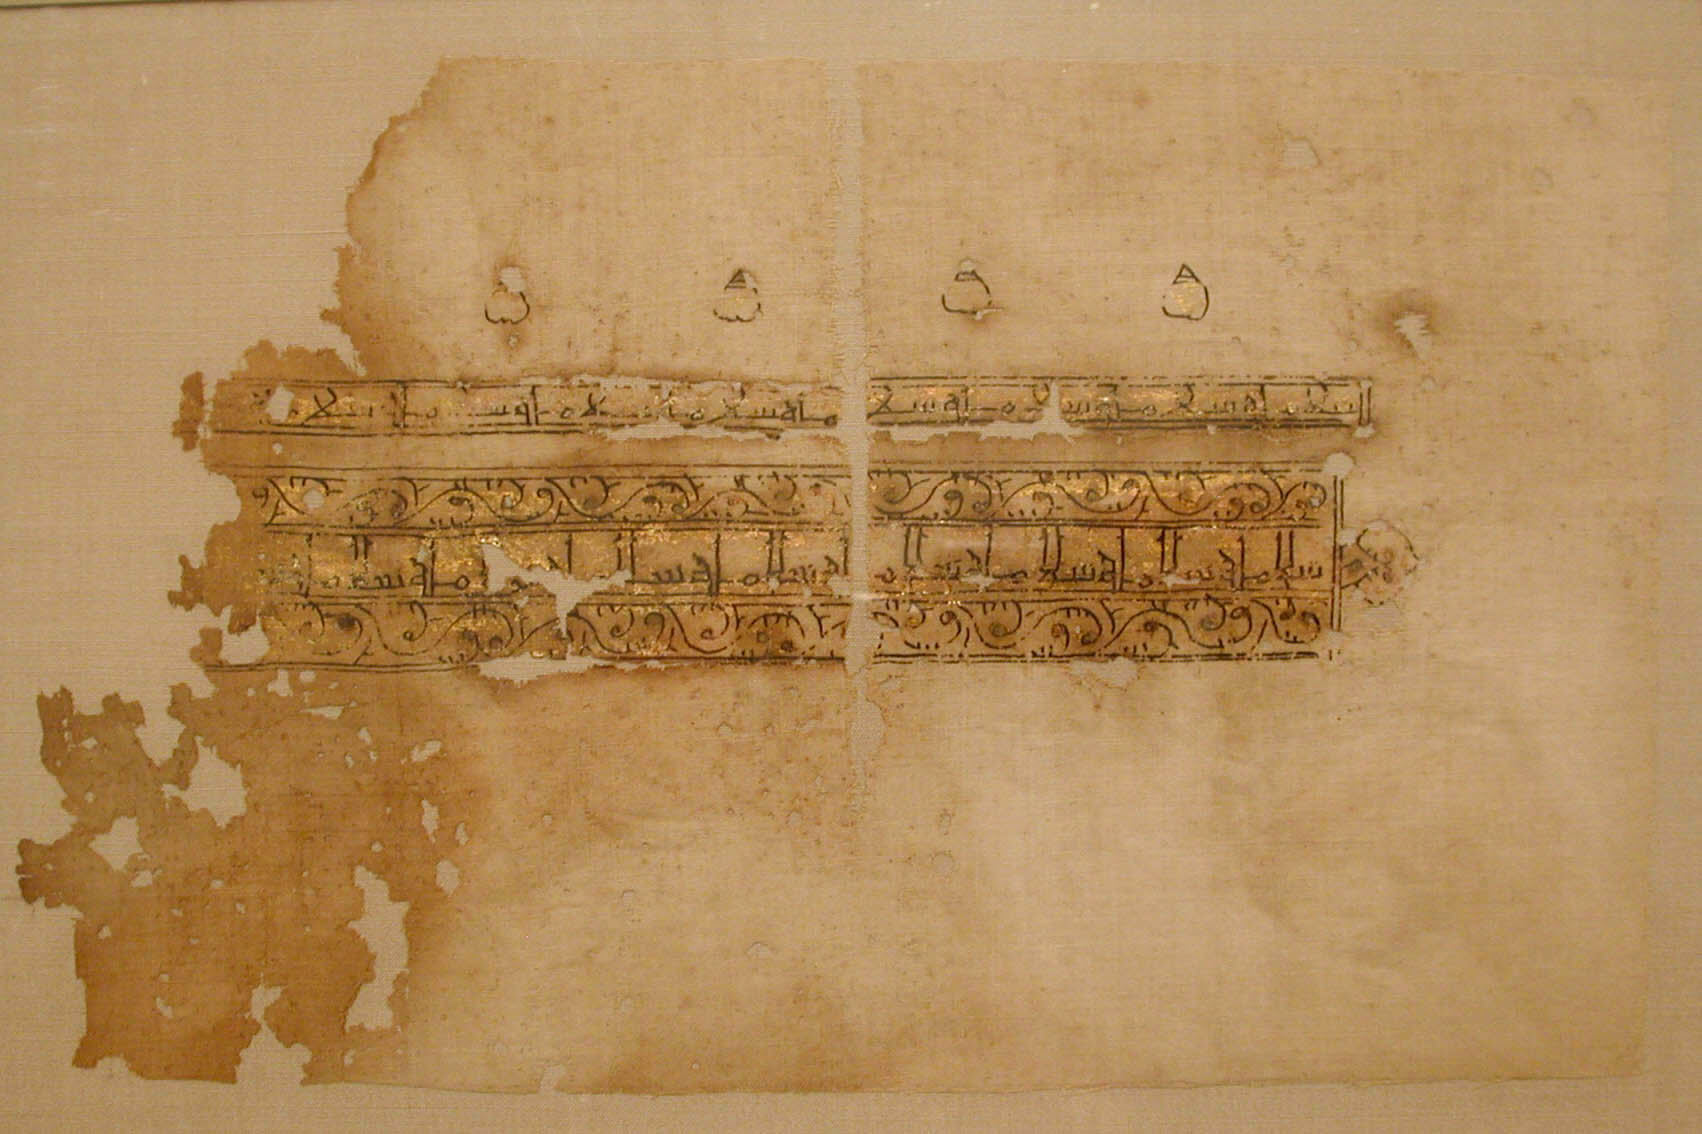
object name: textile fragment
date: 901-1000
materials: linen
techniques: painting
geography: egypt